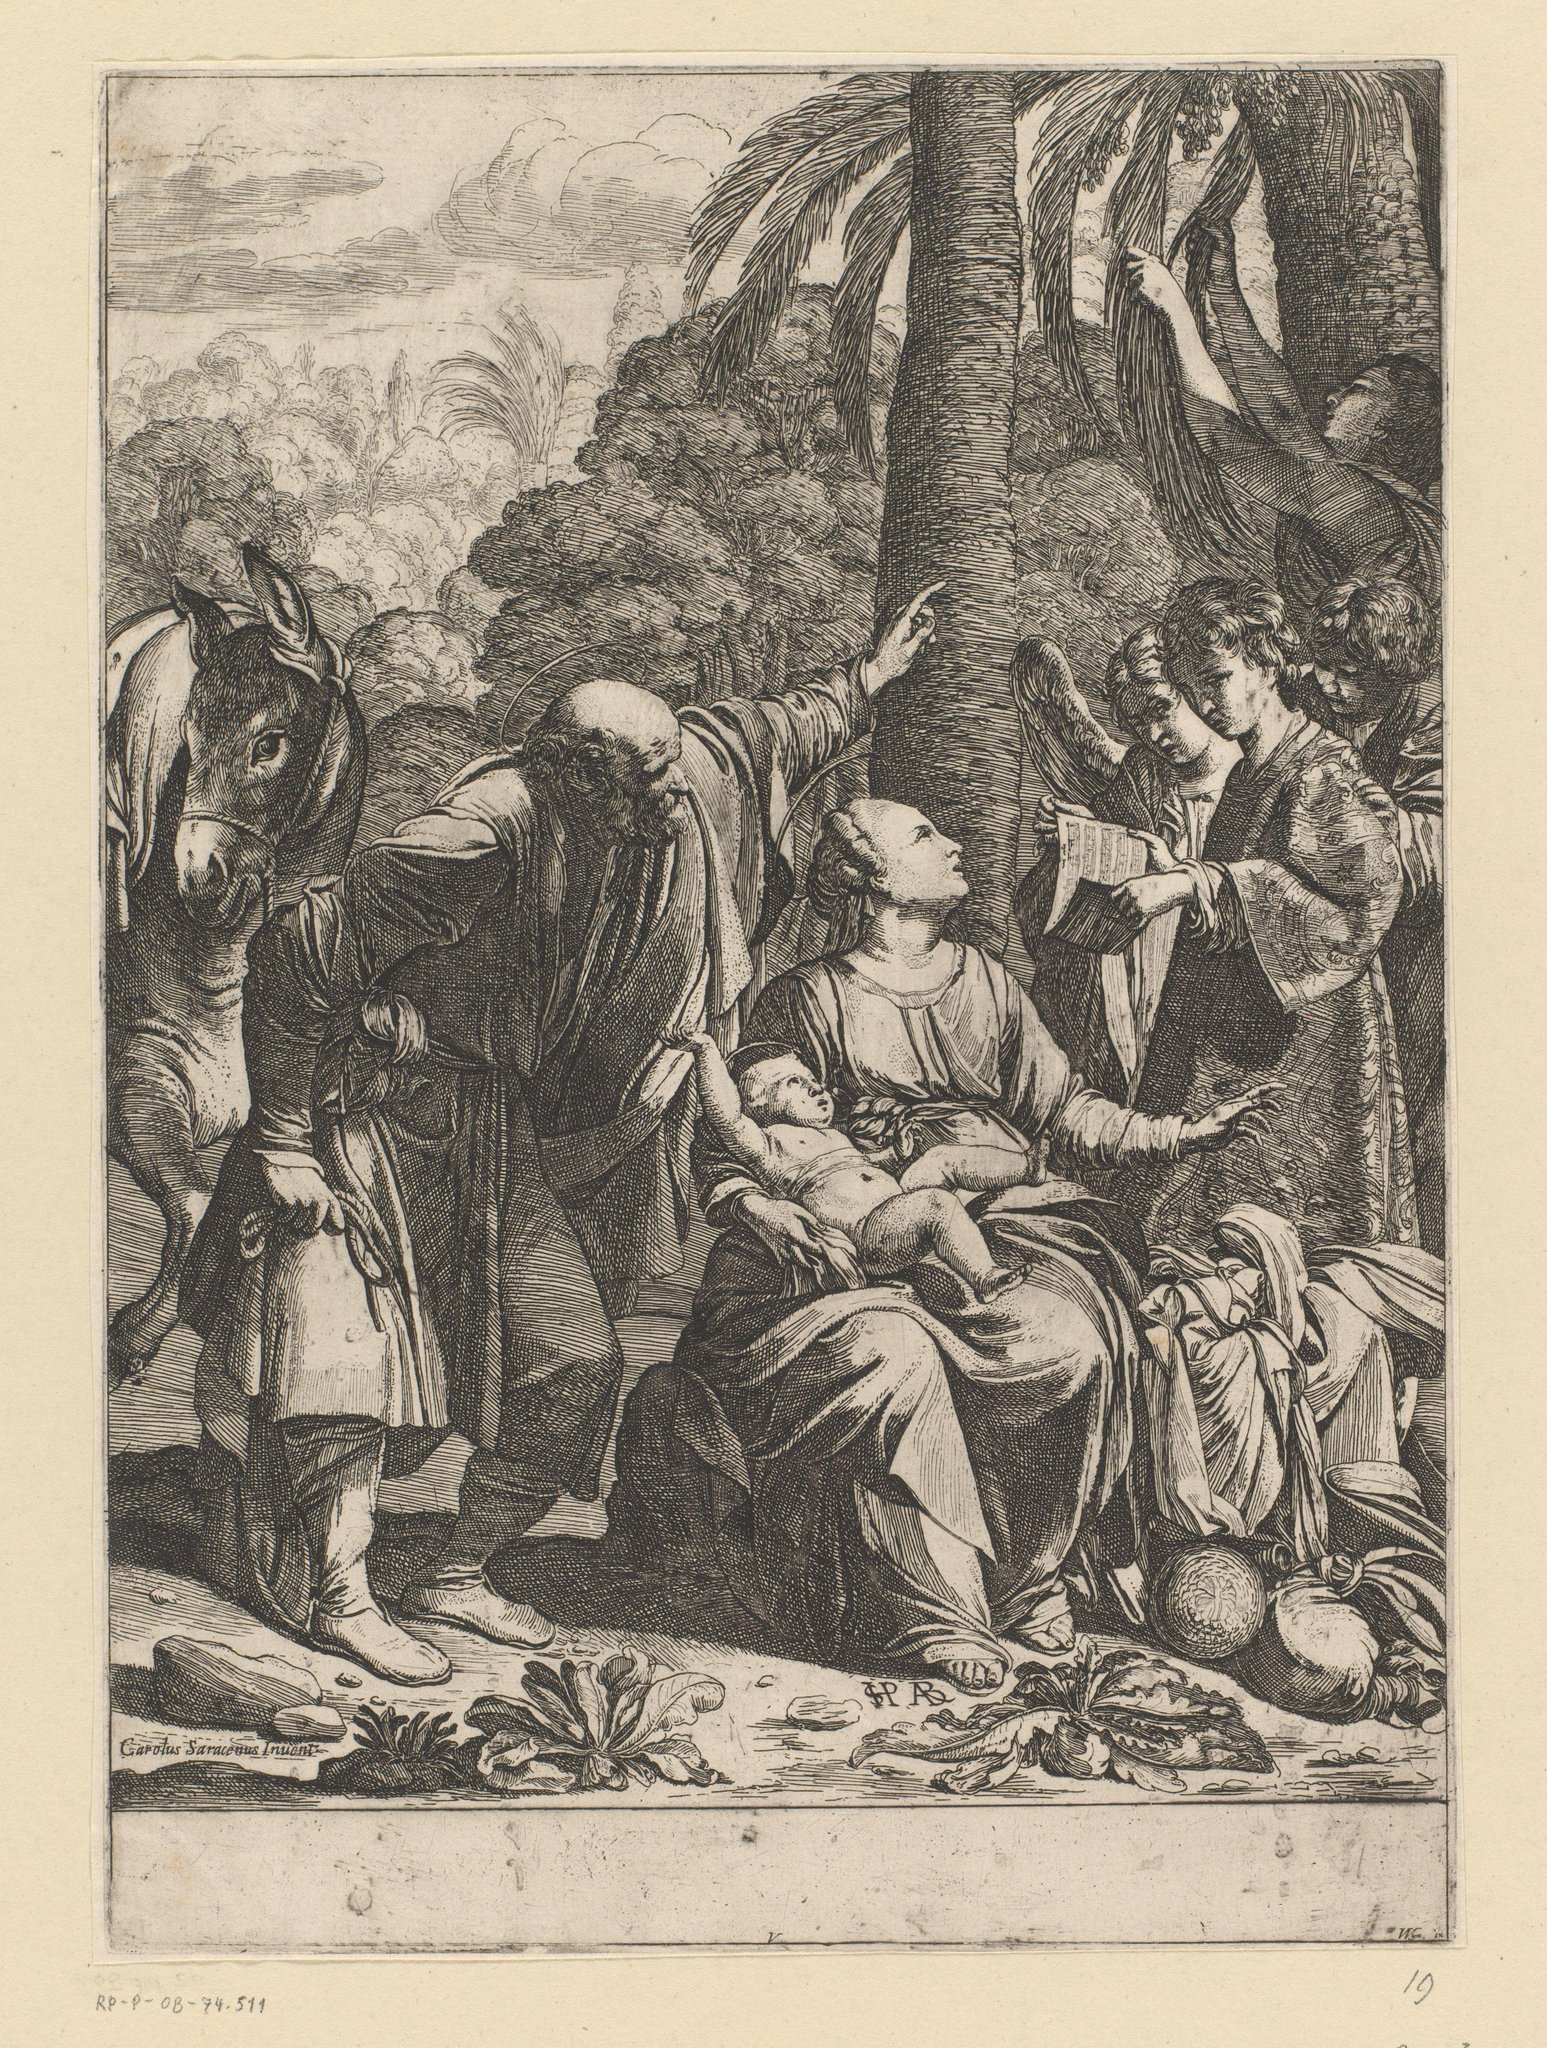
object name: print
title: Rust op de vlucht naar Egypte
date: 1597-1633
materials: paper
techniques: etching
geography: antwerp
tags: miracle of the bending palmtree ~ rest on the flight into egypt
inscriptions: collector's mark: Lugt 240